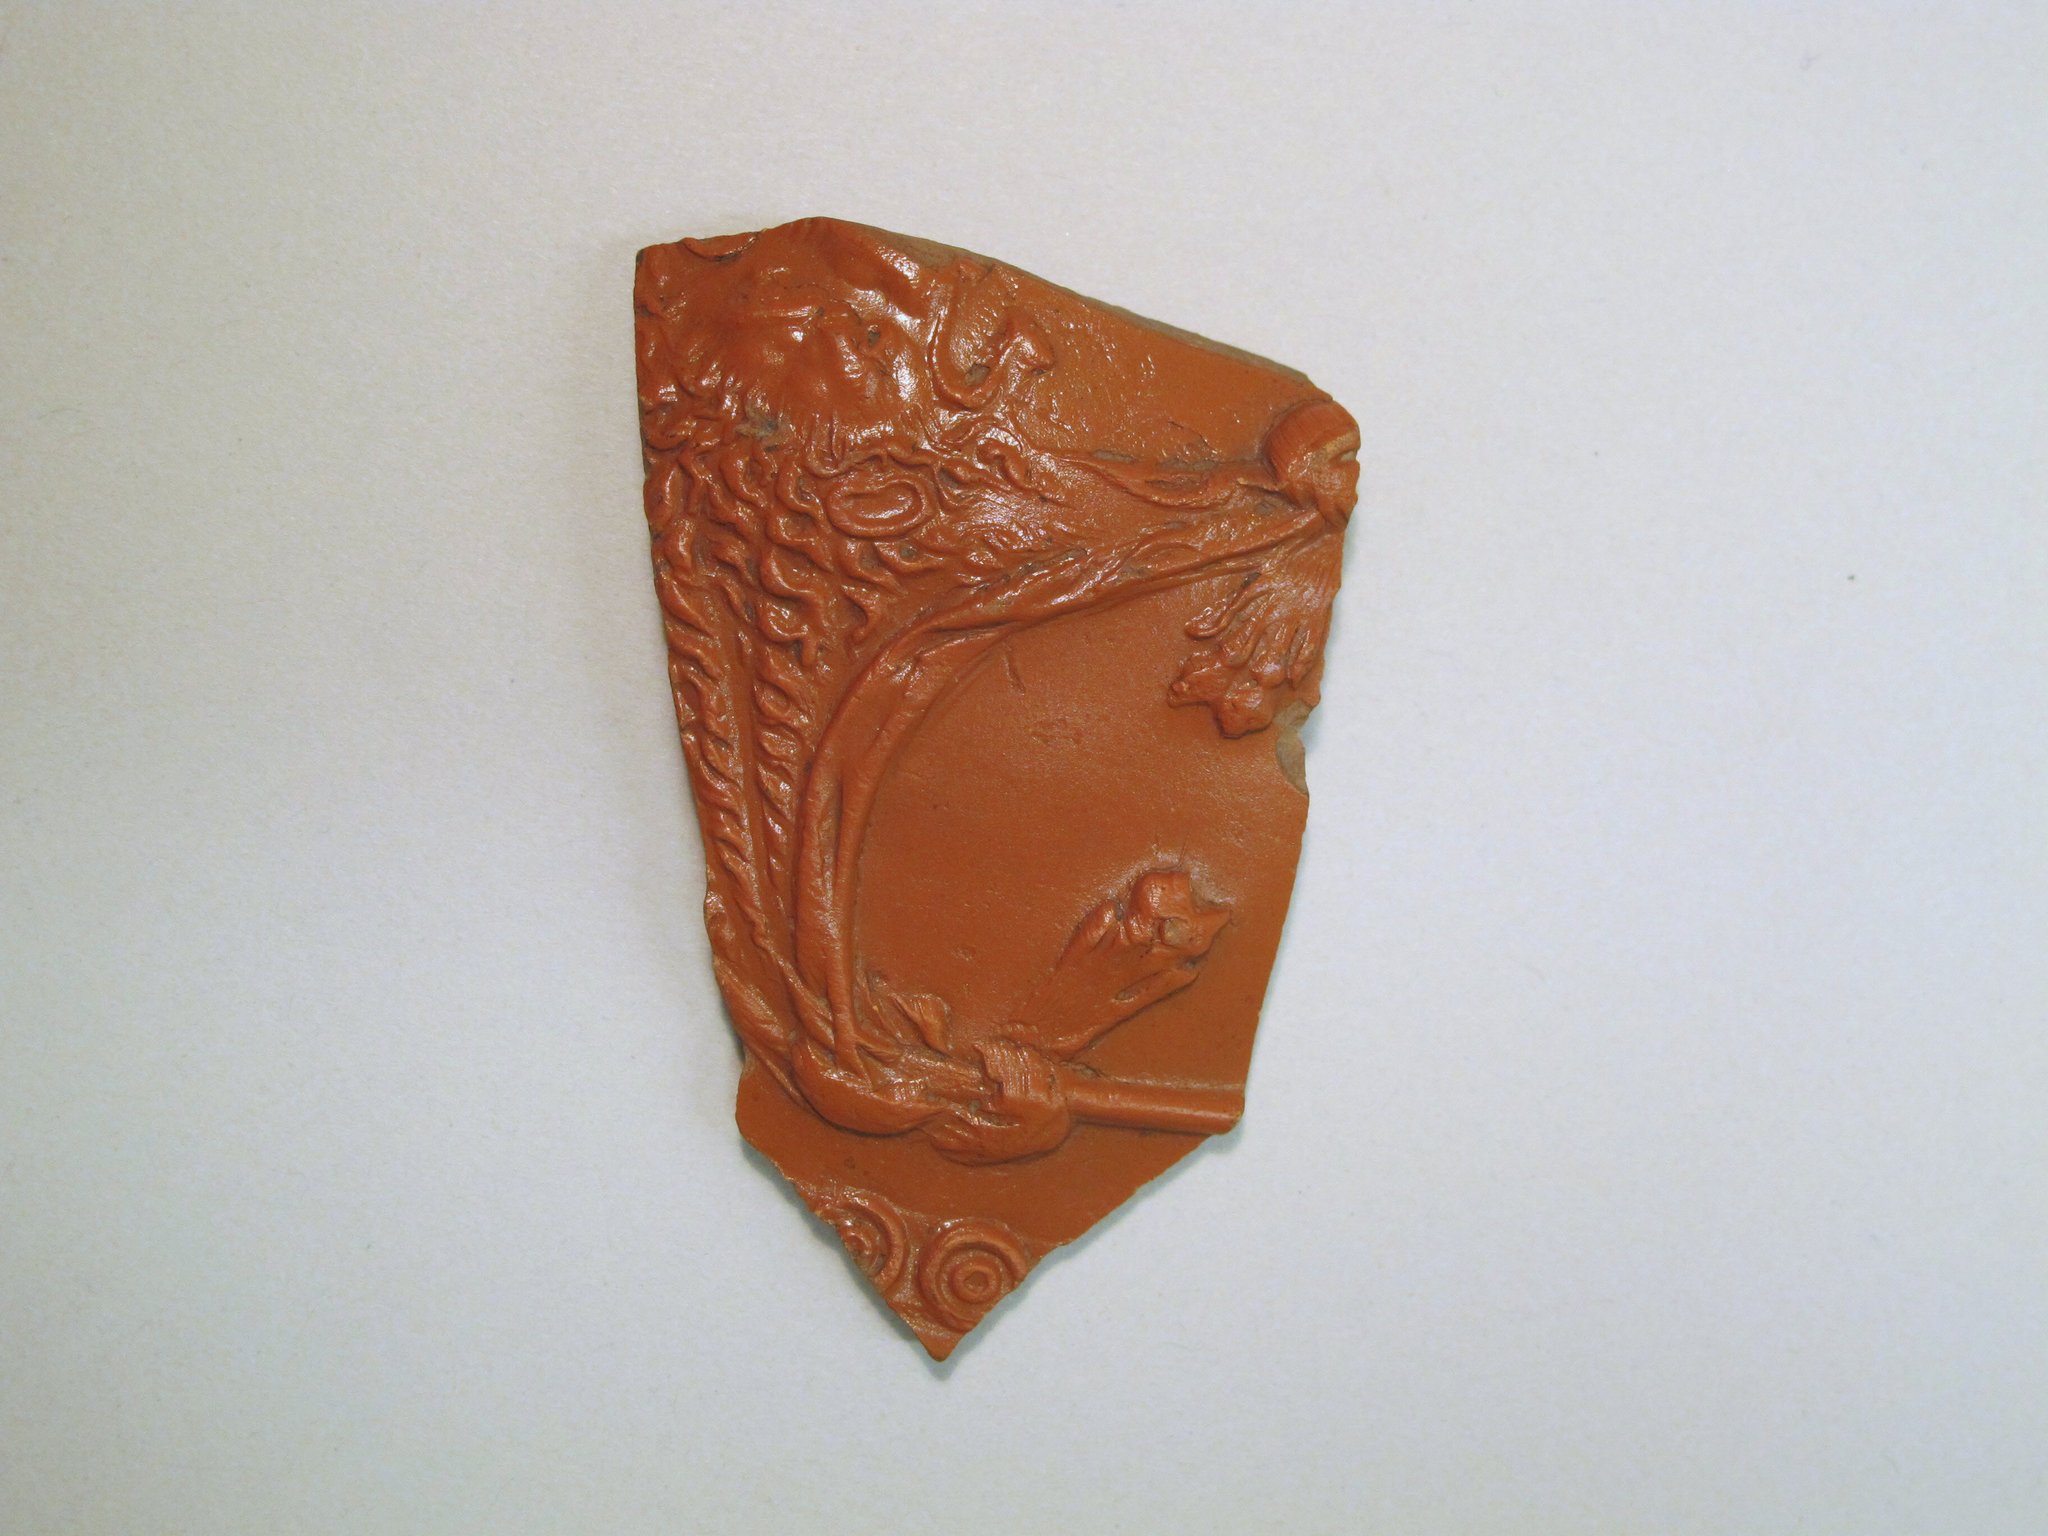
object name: vase fragment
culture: roman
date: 100 BCE-100 CE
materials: terracotta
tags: lions